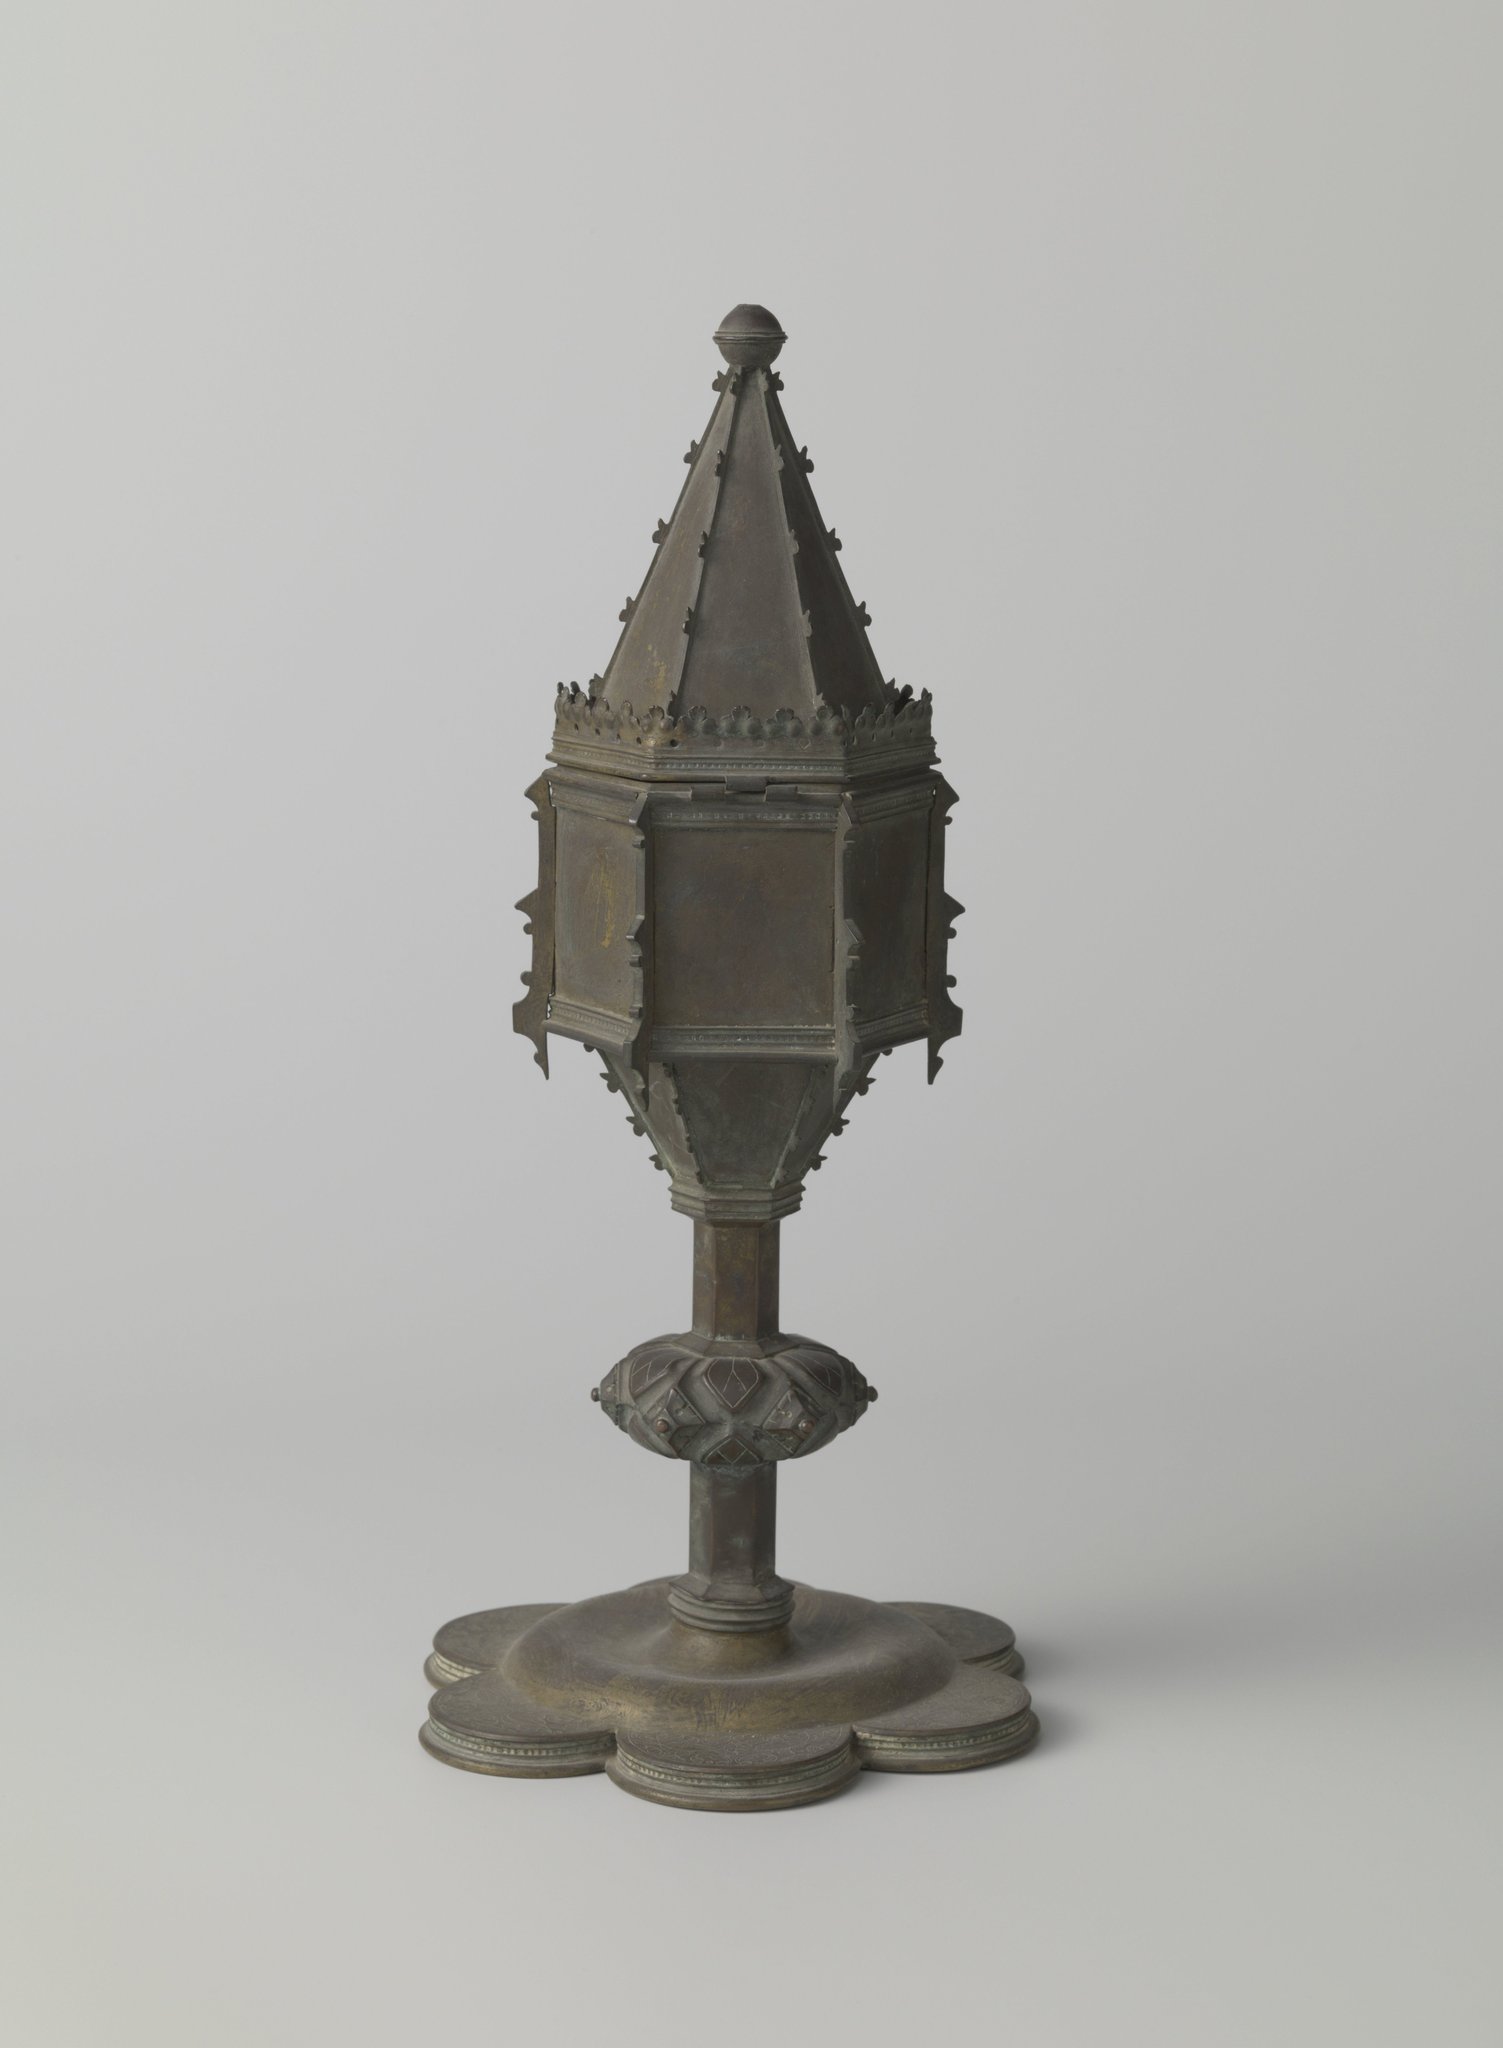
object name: ciborium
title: Ciborie, zeshoekig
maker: Anonymous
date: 1500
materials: brass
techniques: riveted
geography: rhine region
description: Het voorwerp bestaat uit voet, stam, doos en deksel, die merendeels uit stukken plaat zijn gemaakt. De gedeelten van de stam boven en onder de nodus, de verbindingsstukken van de stam met voet en doos, alsmede de horizontale randen langs doos en deksel zijn gegoten. De stam is met drie klinknagels op de voet bevestigd. In de bodem van de doos zijn in het midden zes klinknagels aangebracht en twaalflangs de kanten. Het deksel is scharnierend bevestigd aan de doos en heeft een pensluiting. De voet loopt uit in zes met bladornament versierde lobben. Zijn middendeel heeft in doorsnede een accoladeprofiel. Stam, nodus, doos en deksel zijn uit zes vlakken opgebouwd. De nodus is voorzien van zes met knoppen versierde facetten, zes gestileerde bladeren aan de bovenkant en zes aan de onderkant. De overgang van stam naar doos verbreedt zich naar boven toe en heeft een hoge versiering op de raaklijnen van de zes vlakken. Het deksel is voorzien van een opstaande rand van acanthusblad, en eindigt in een knop, waarvan het kruis is afgebroken.